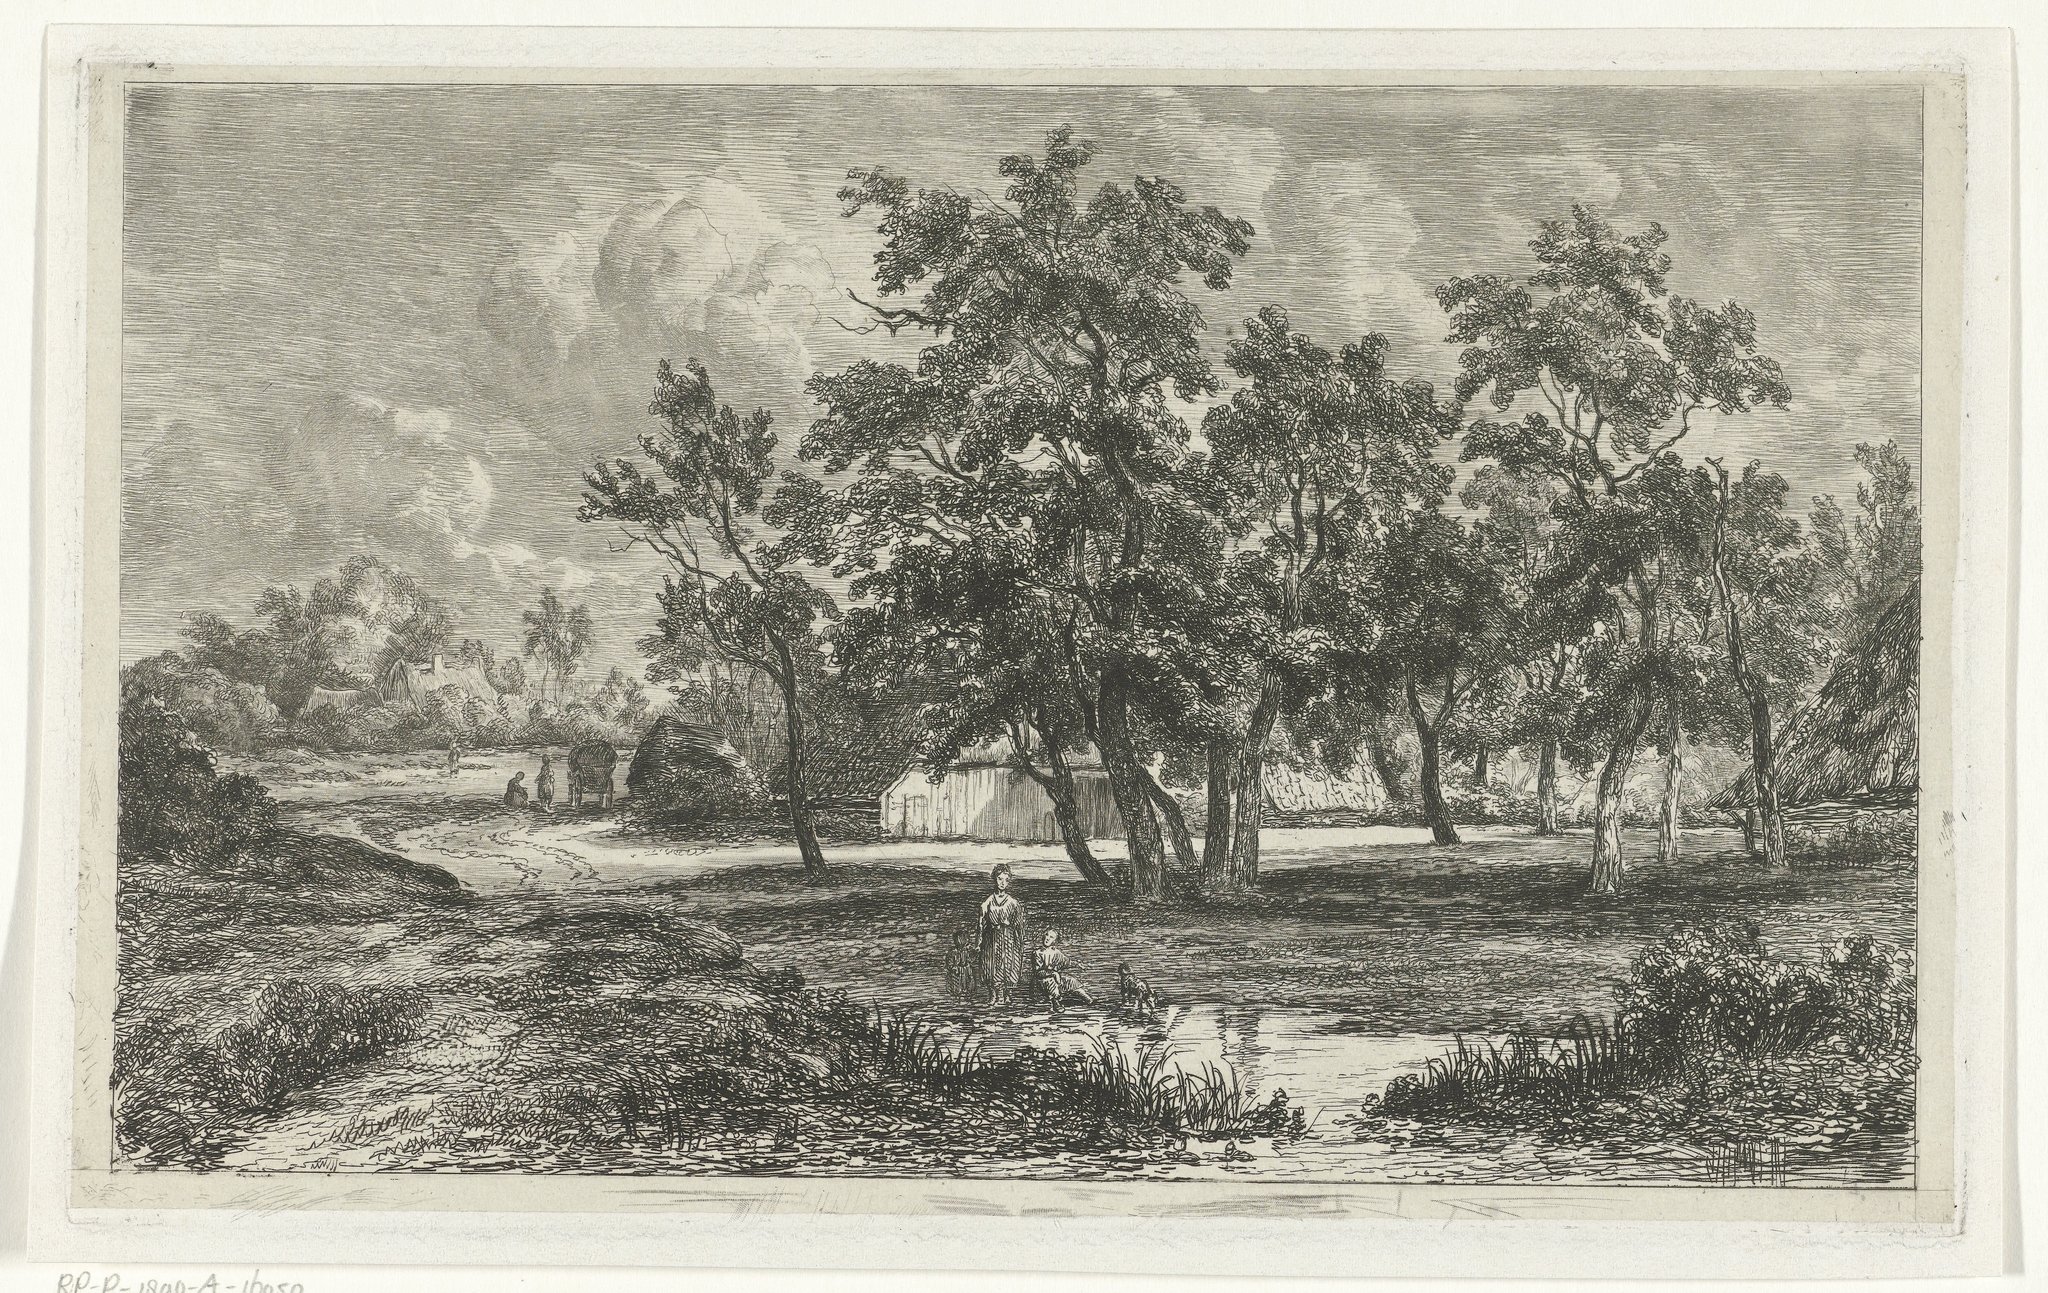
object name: print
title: Landschap met boerderij tussen de bomen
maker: christiaan immerzeel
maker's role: print maker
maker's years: 1808-1886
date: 1818-1886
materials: paper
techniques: etching, roulette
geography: netherlands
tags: landscapes (+ landscape with figures, staffage), farm or solitary house in landscape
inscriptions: collector's mark: Lugt 2228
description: Landschap met drie figuren en een hond bij een waterplas. Daarachter ligt een boerderij tussen de bomen. Links een weg met figuren en een kar.